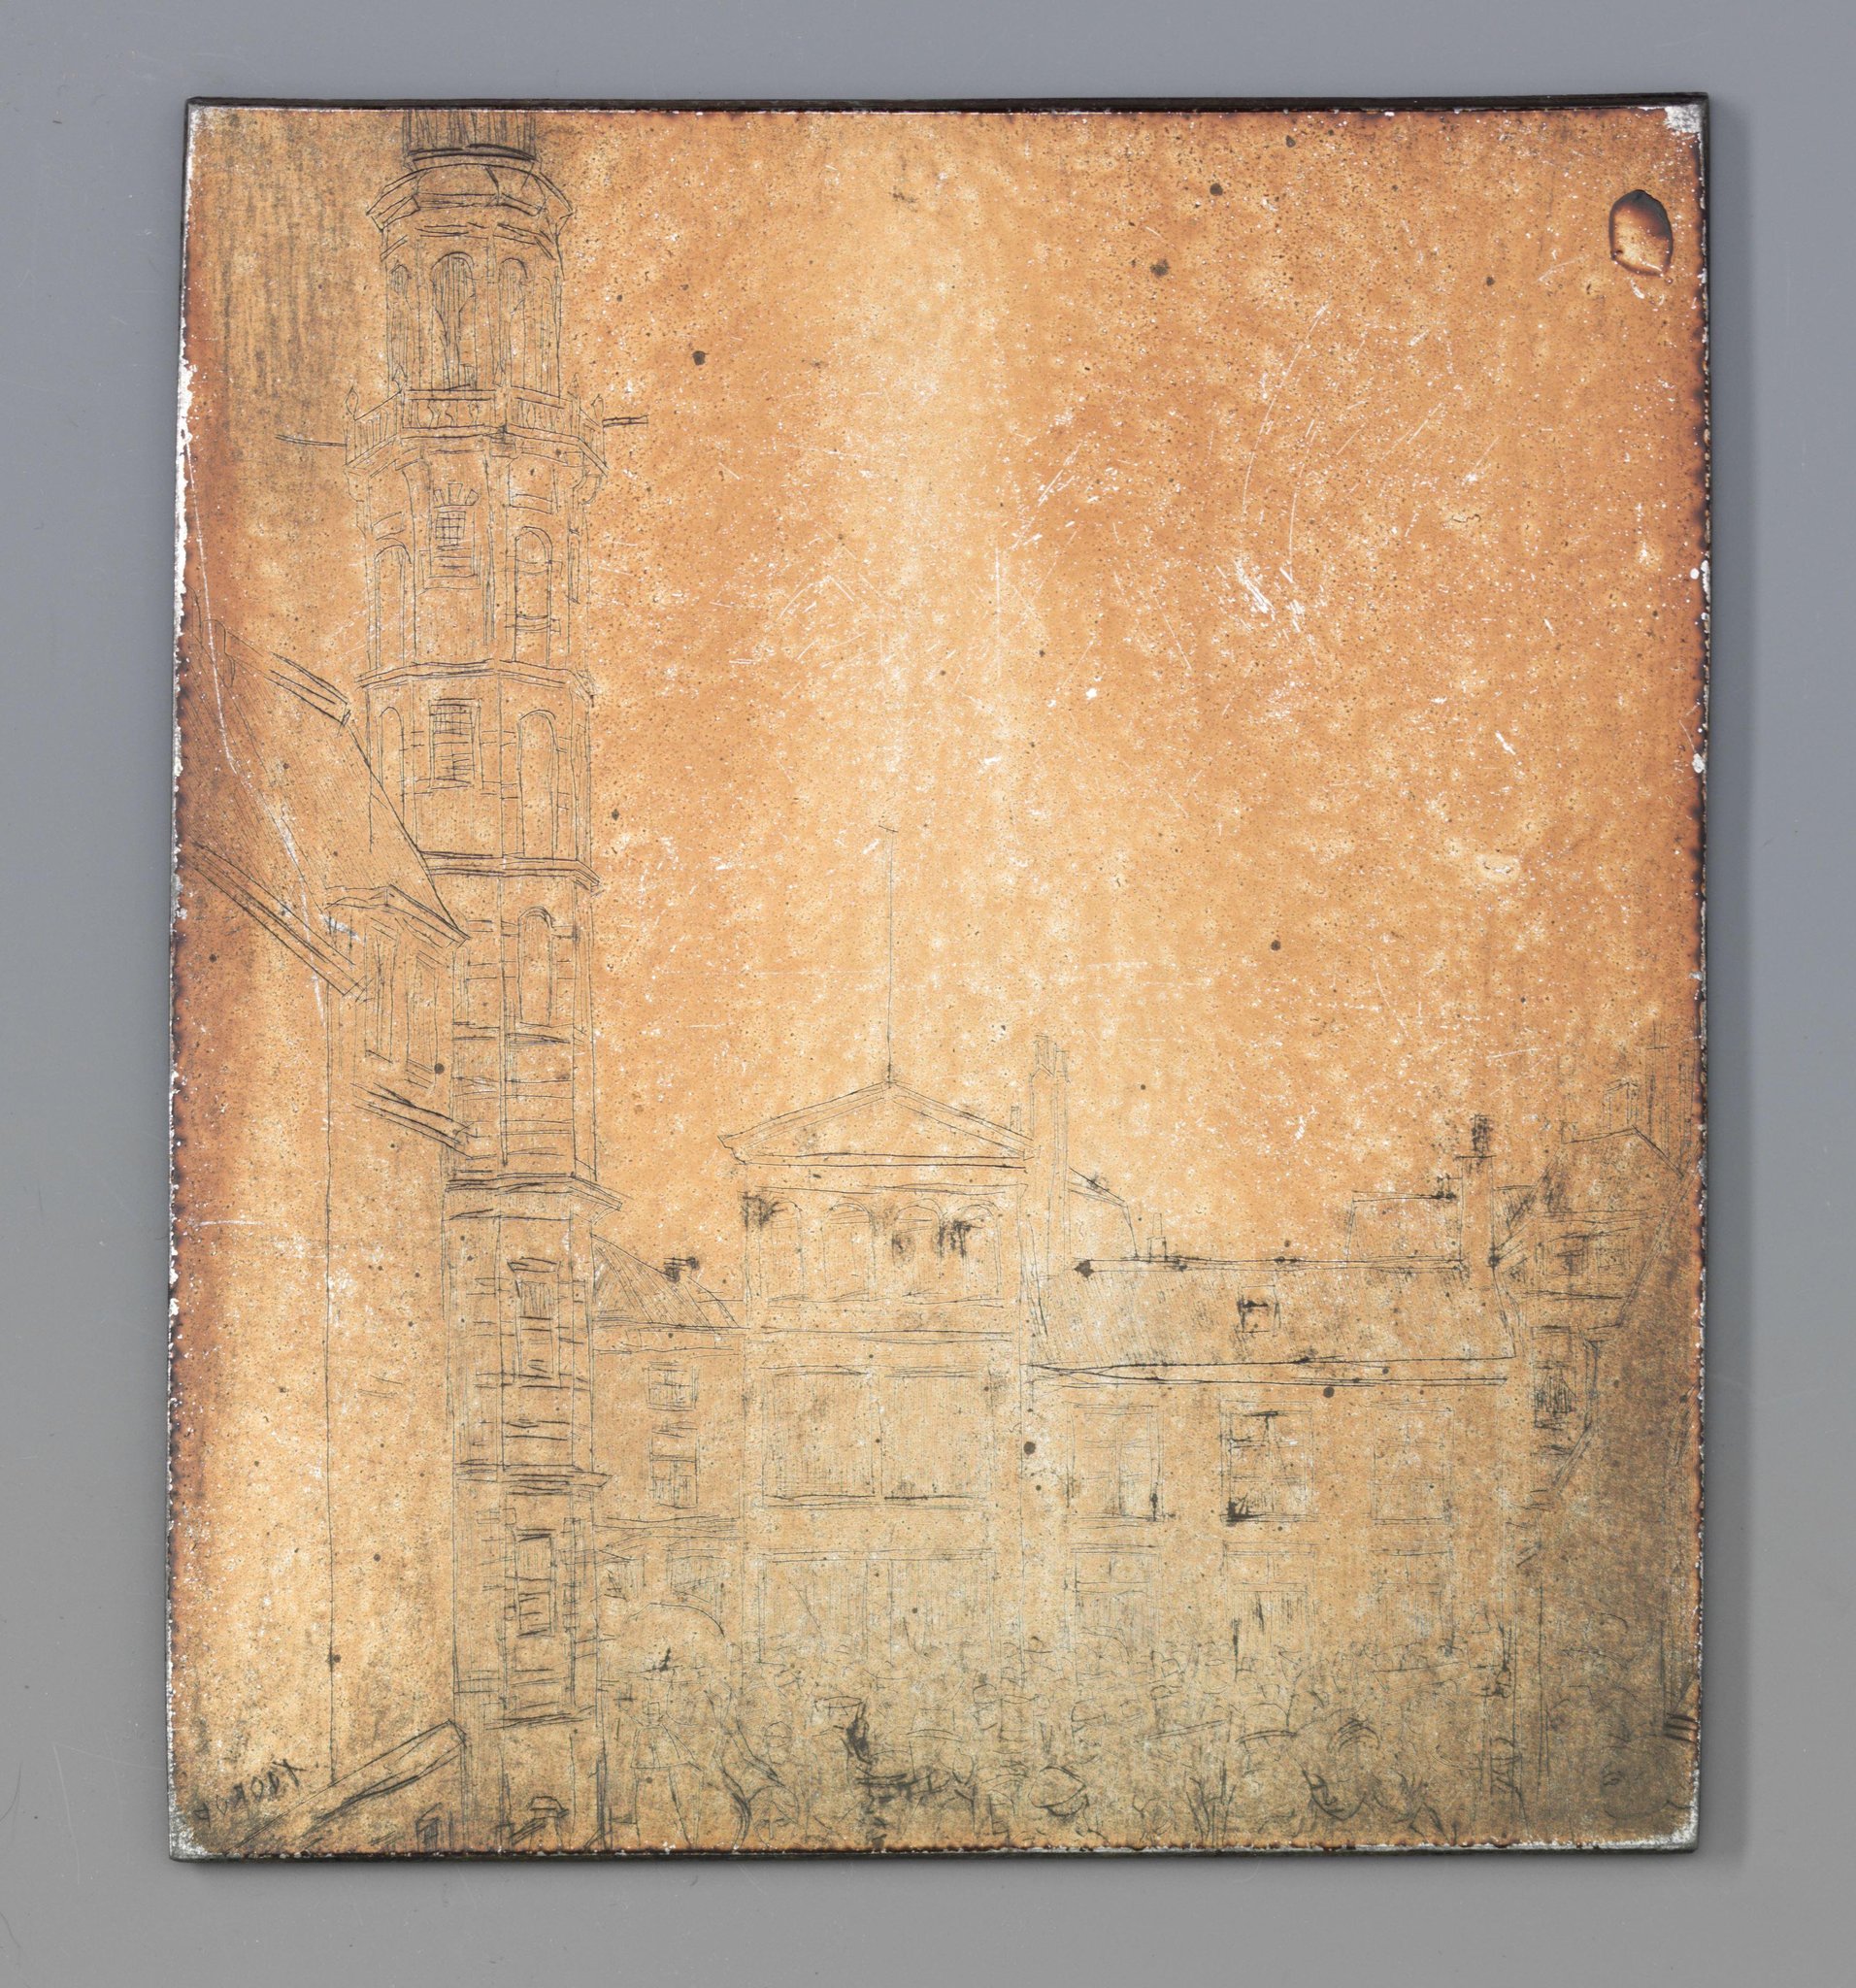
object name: zinkplaat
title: Stadhuis in Den Haag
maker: jan toorop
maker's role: draughtsman, painter, print maker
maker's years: 1858-1928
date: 1900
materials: zinc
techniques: drypoint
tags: stadhuis